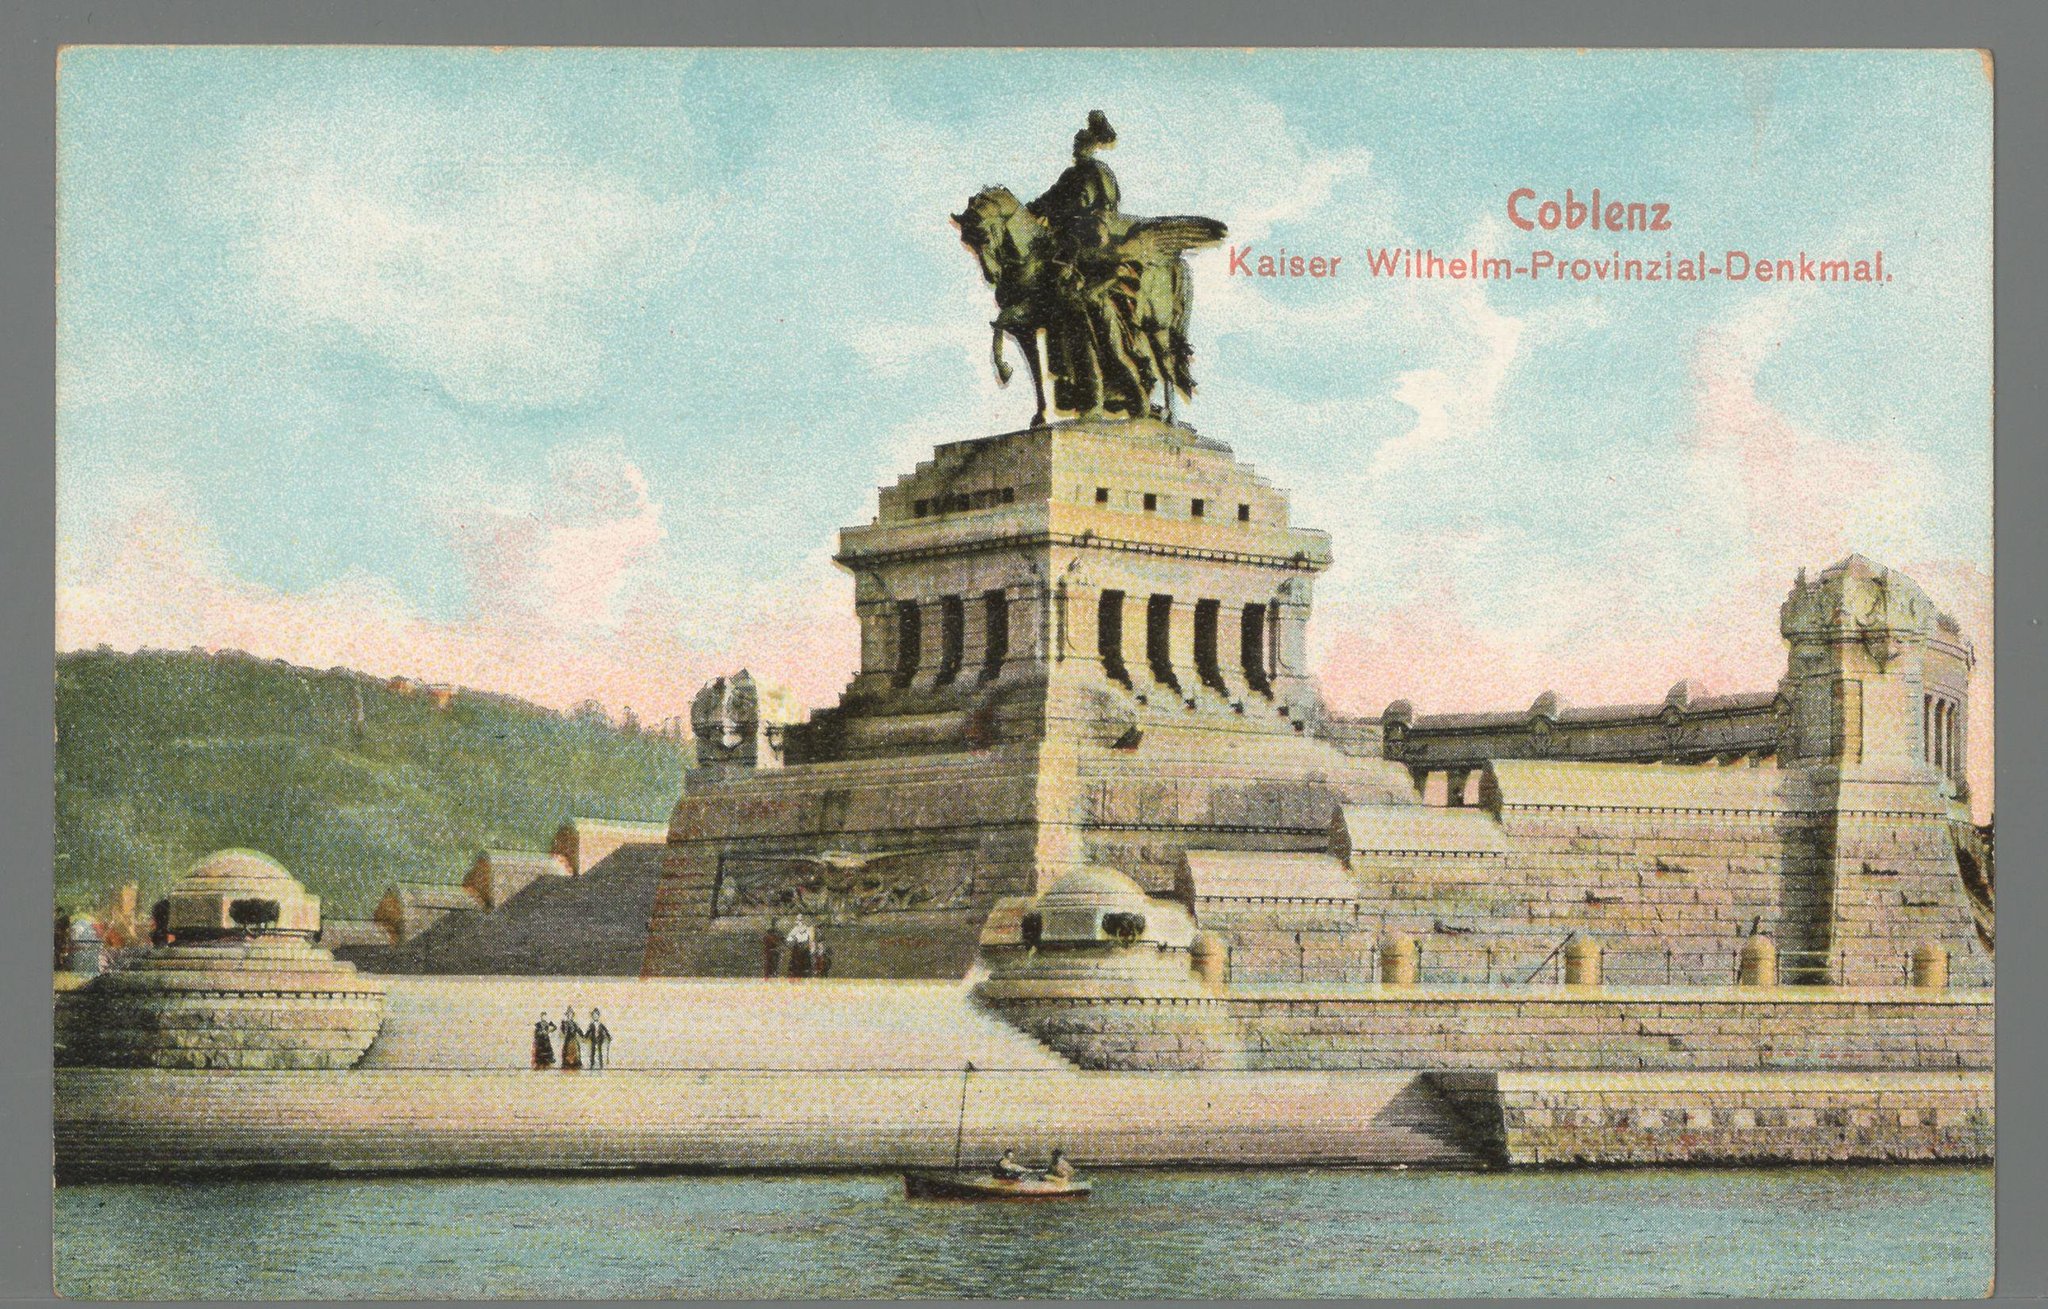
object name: ansichtkaart, prentbriefkaart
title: Coblenz. Kaiser Wilhelm-Provinzial-Denkmal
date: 1905-1930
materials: cardboard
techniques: lithograph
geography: koblenz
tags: berlin, wilhelm i (keizer van duitsland), monument, statue, canals, waters (in city)